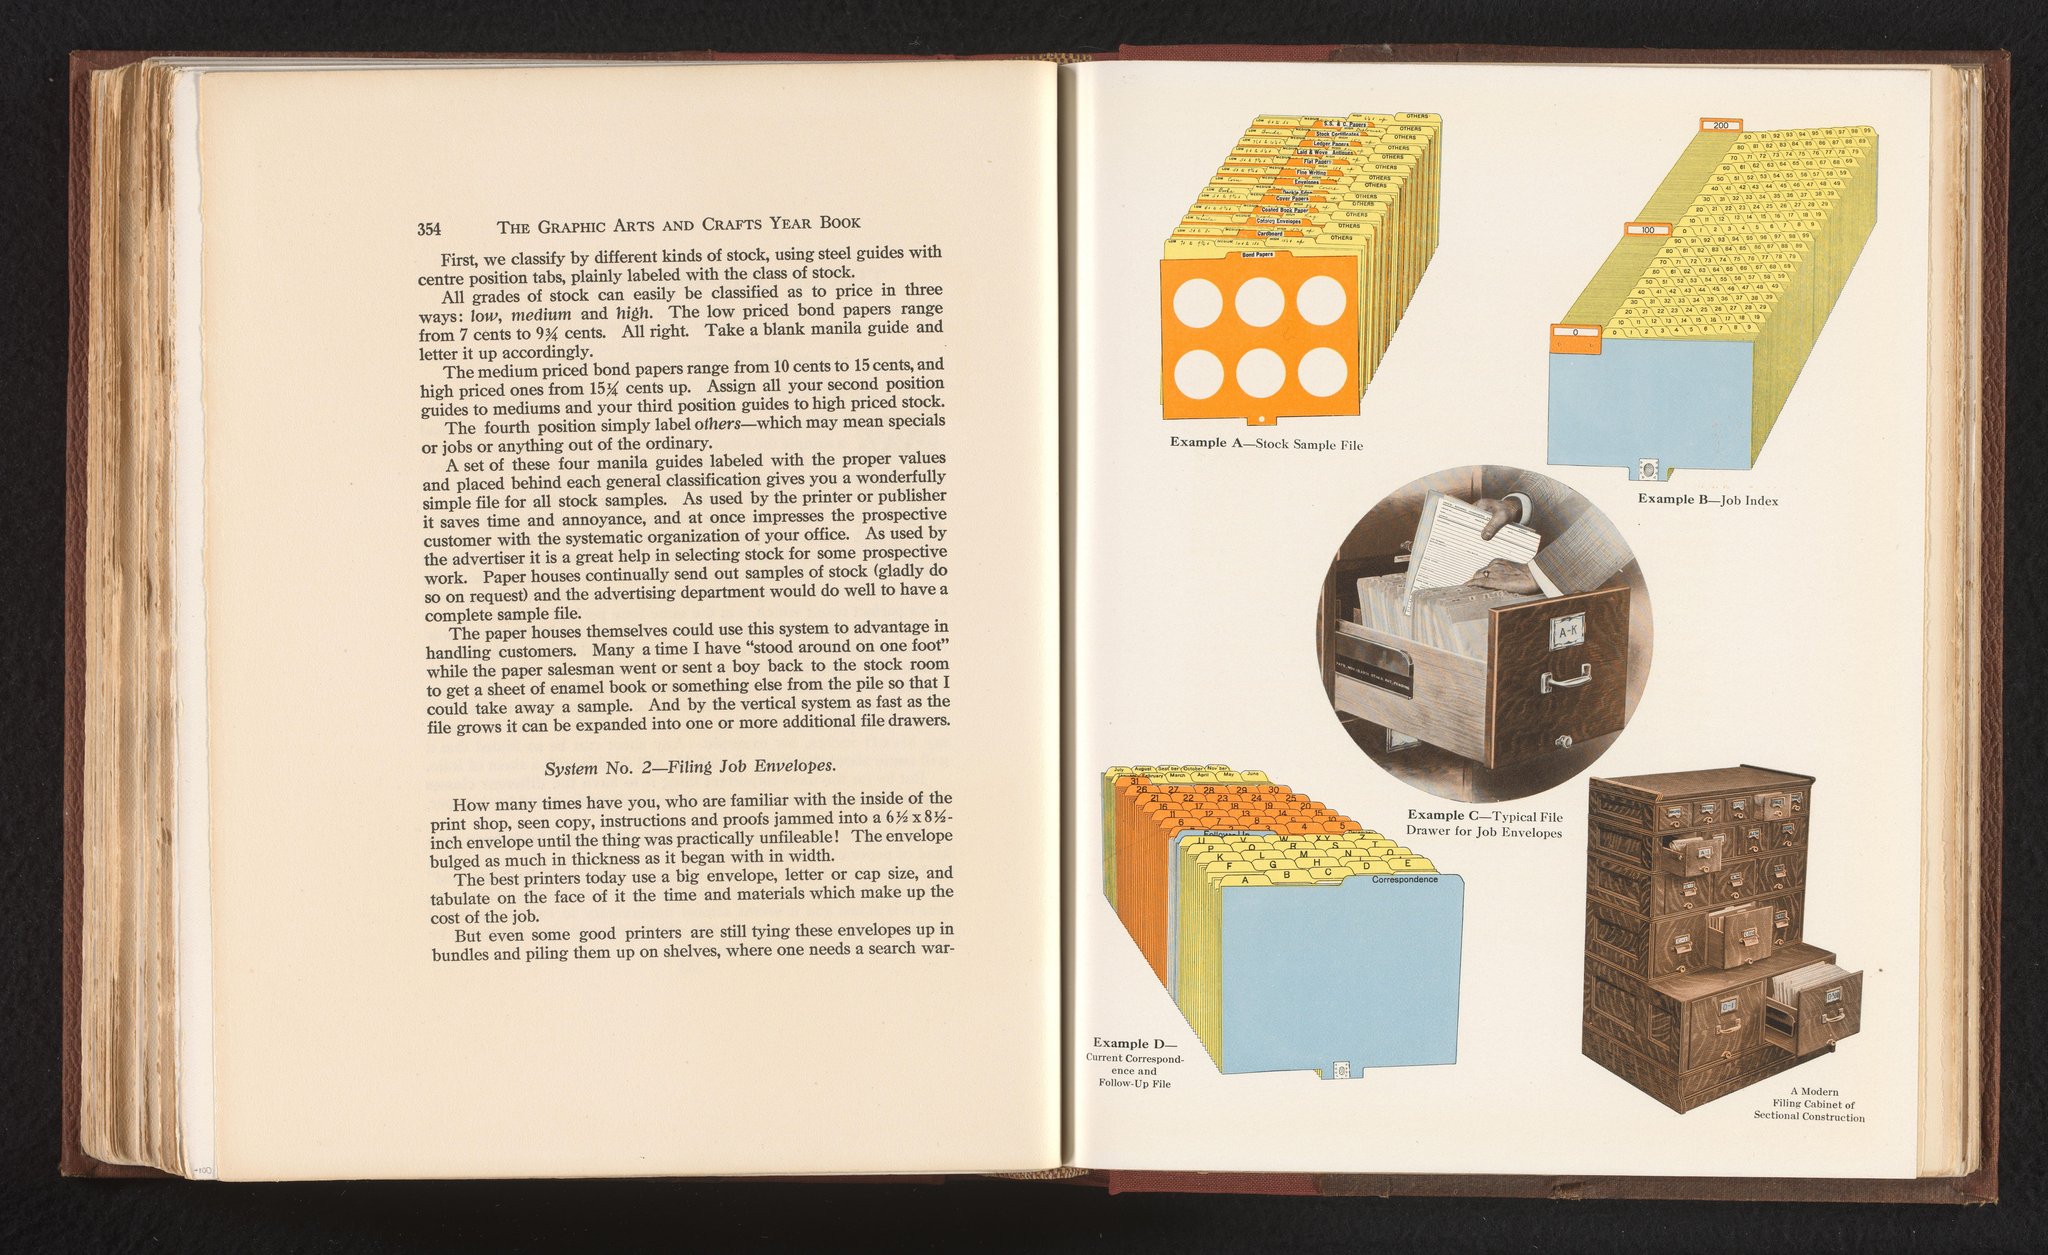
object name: page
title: Reclame met twee fotomechanische afdrukken voor opbergsystemen van Yayman & Erbe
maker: Anonymous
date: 1904-1909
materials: paper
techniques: color autotype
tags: furniture for storage